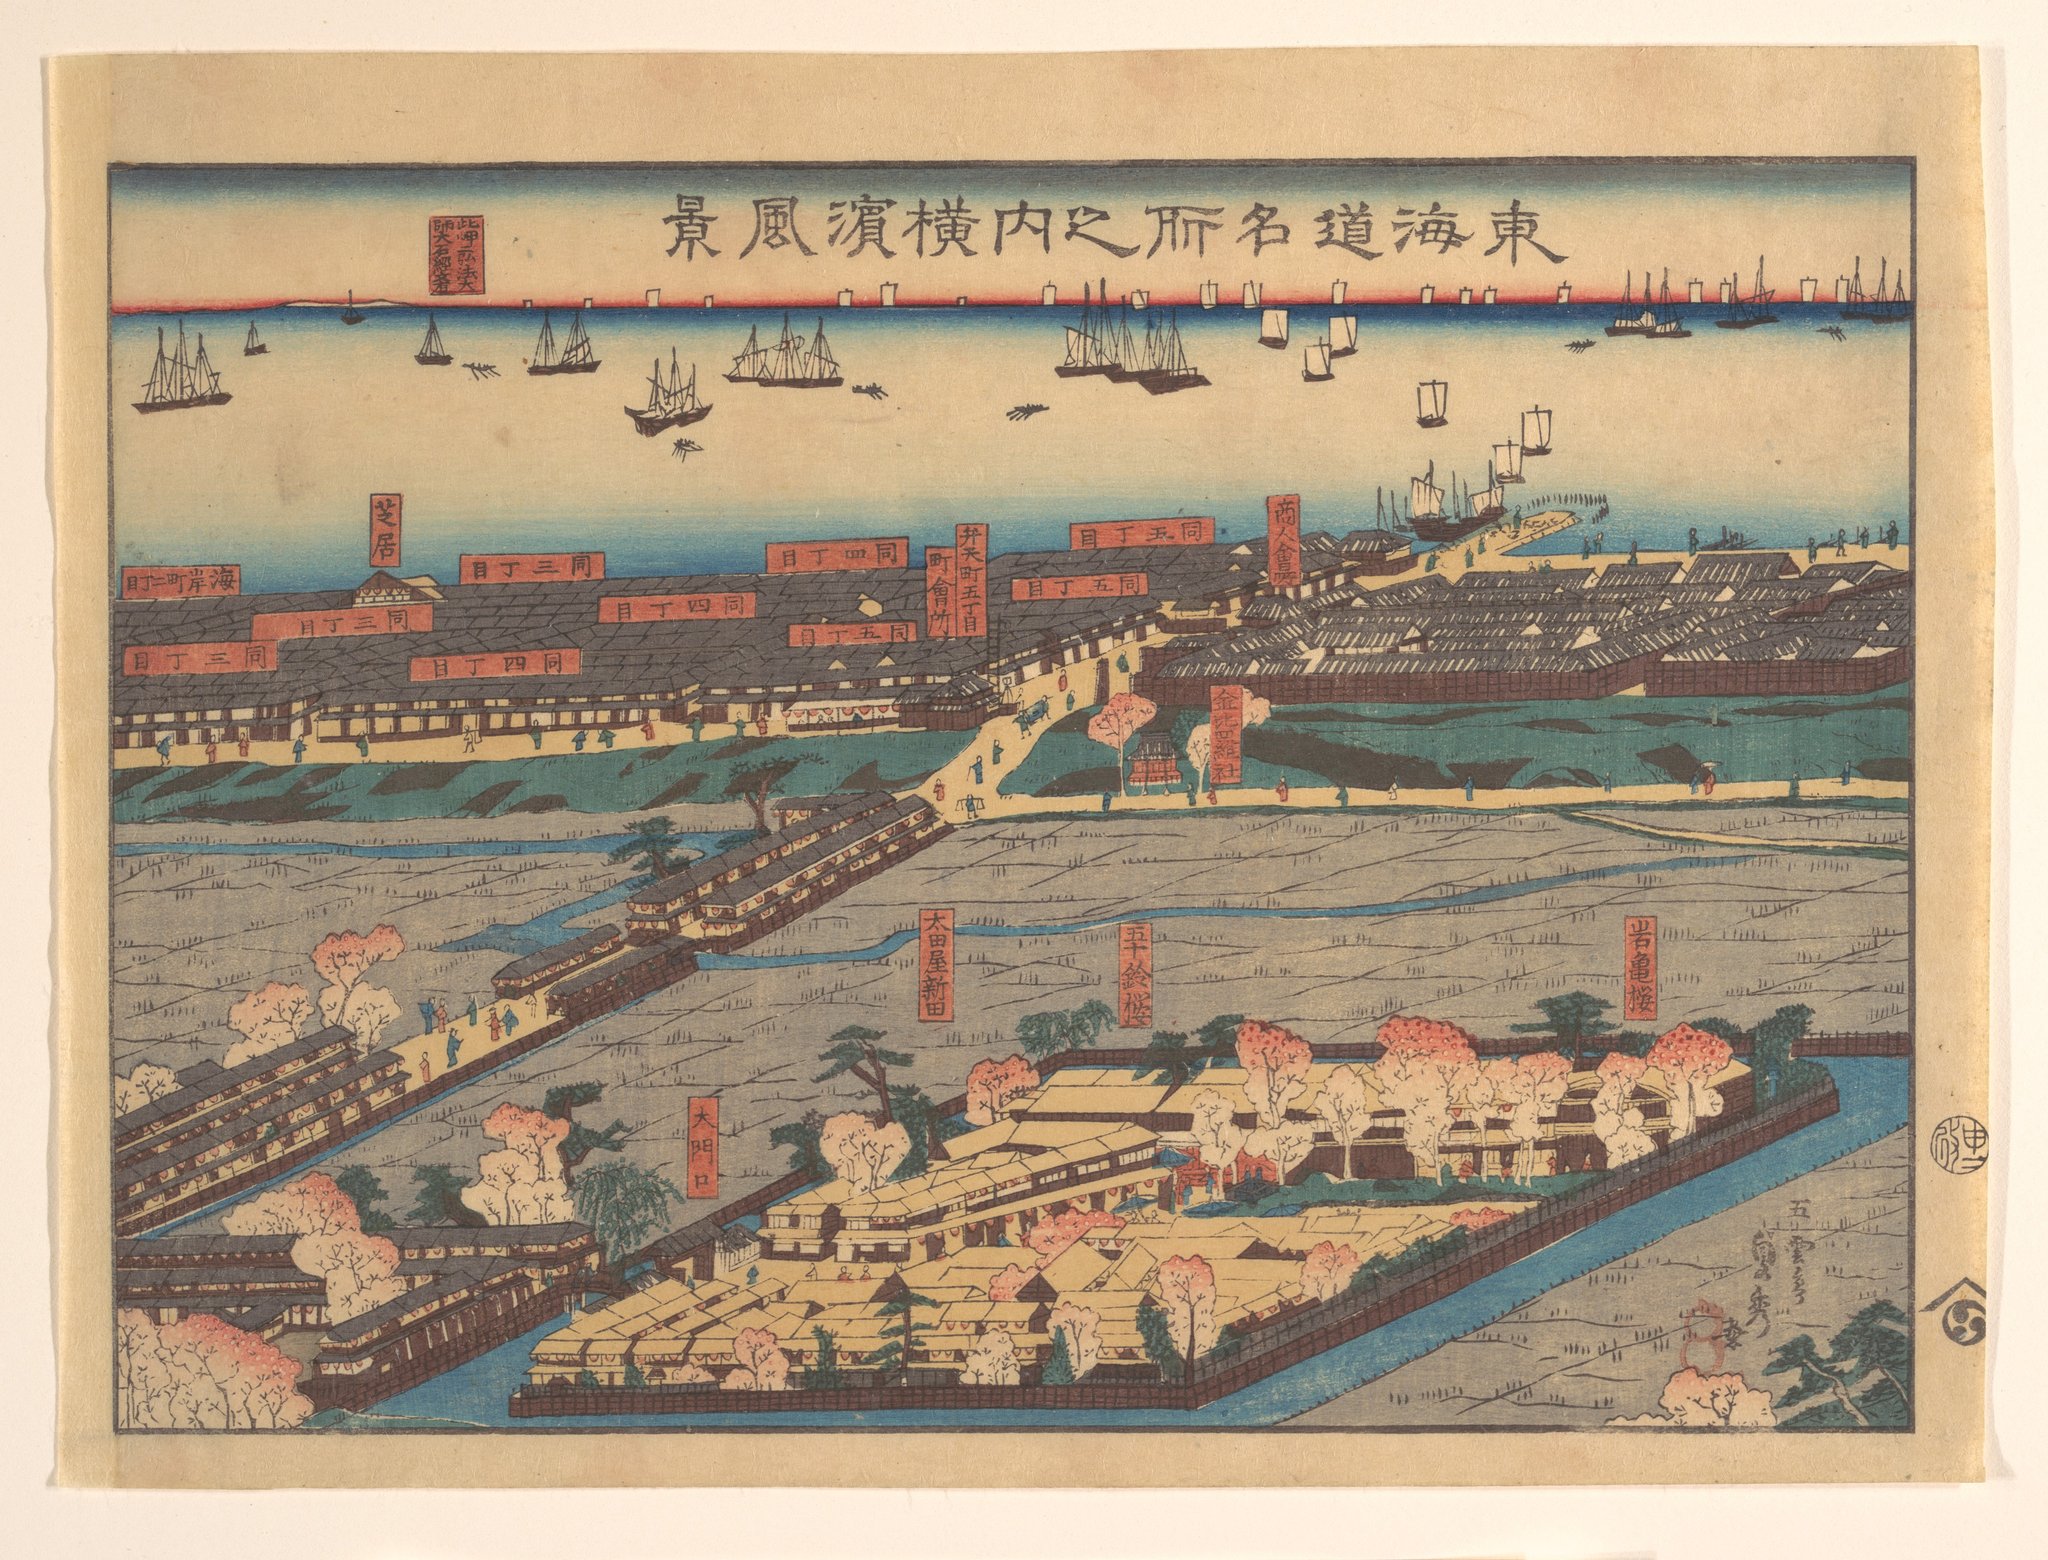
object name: print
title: Landscape View at Yokohama (Yokohama fūkei)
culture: japanese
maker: utagawa (gountei) sadahide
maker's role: artist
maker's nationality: japanese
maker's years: 1807-1873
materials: ink, paper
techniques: woodblock print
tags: buildings,landscapes,ships